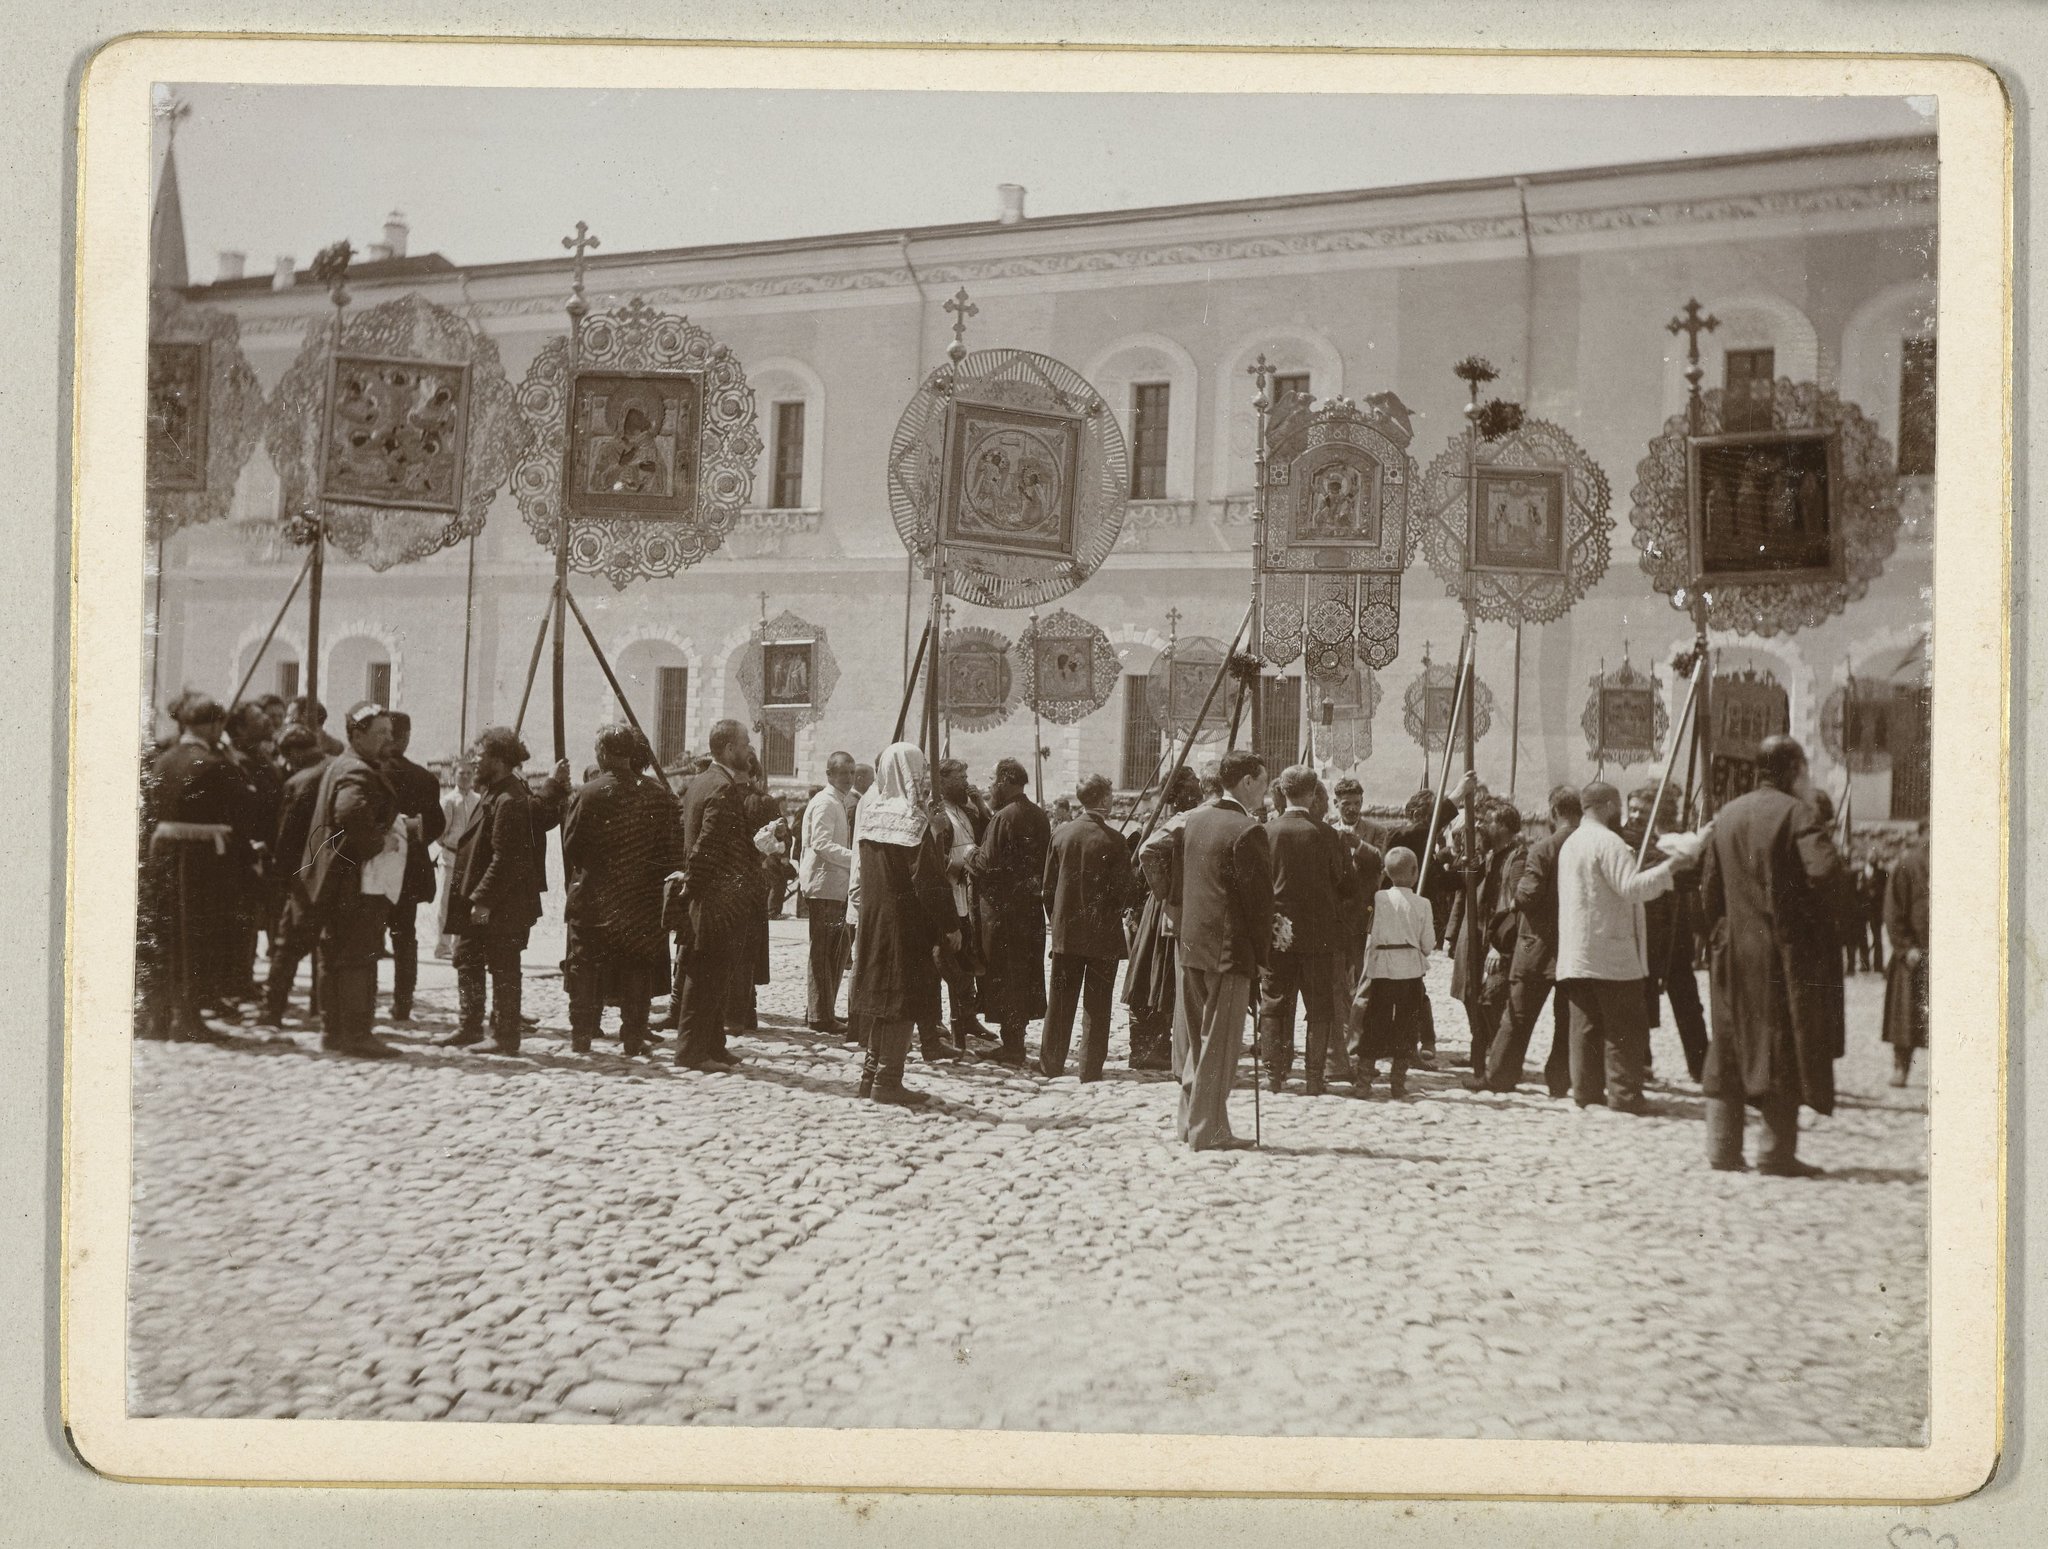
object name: photograph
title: Processie met religieuze afbeeldingen op het Kremlin.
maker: henry pauw van wieldrecht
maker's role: fotograaf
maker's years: 1863-1912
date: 1898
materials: paper, photographic support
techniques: albumen print